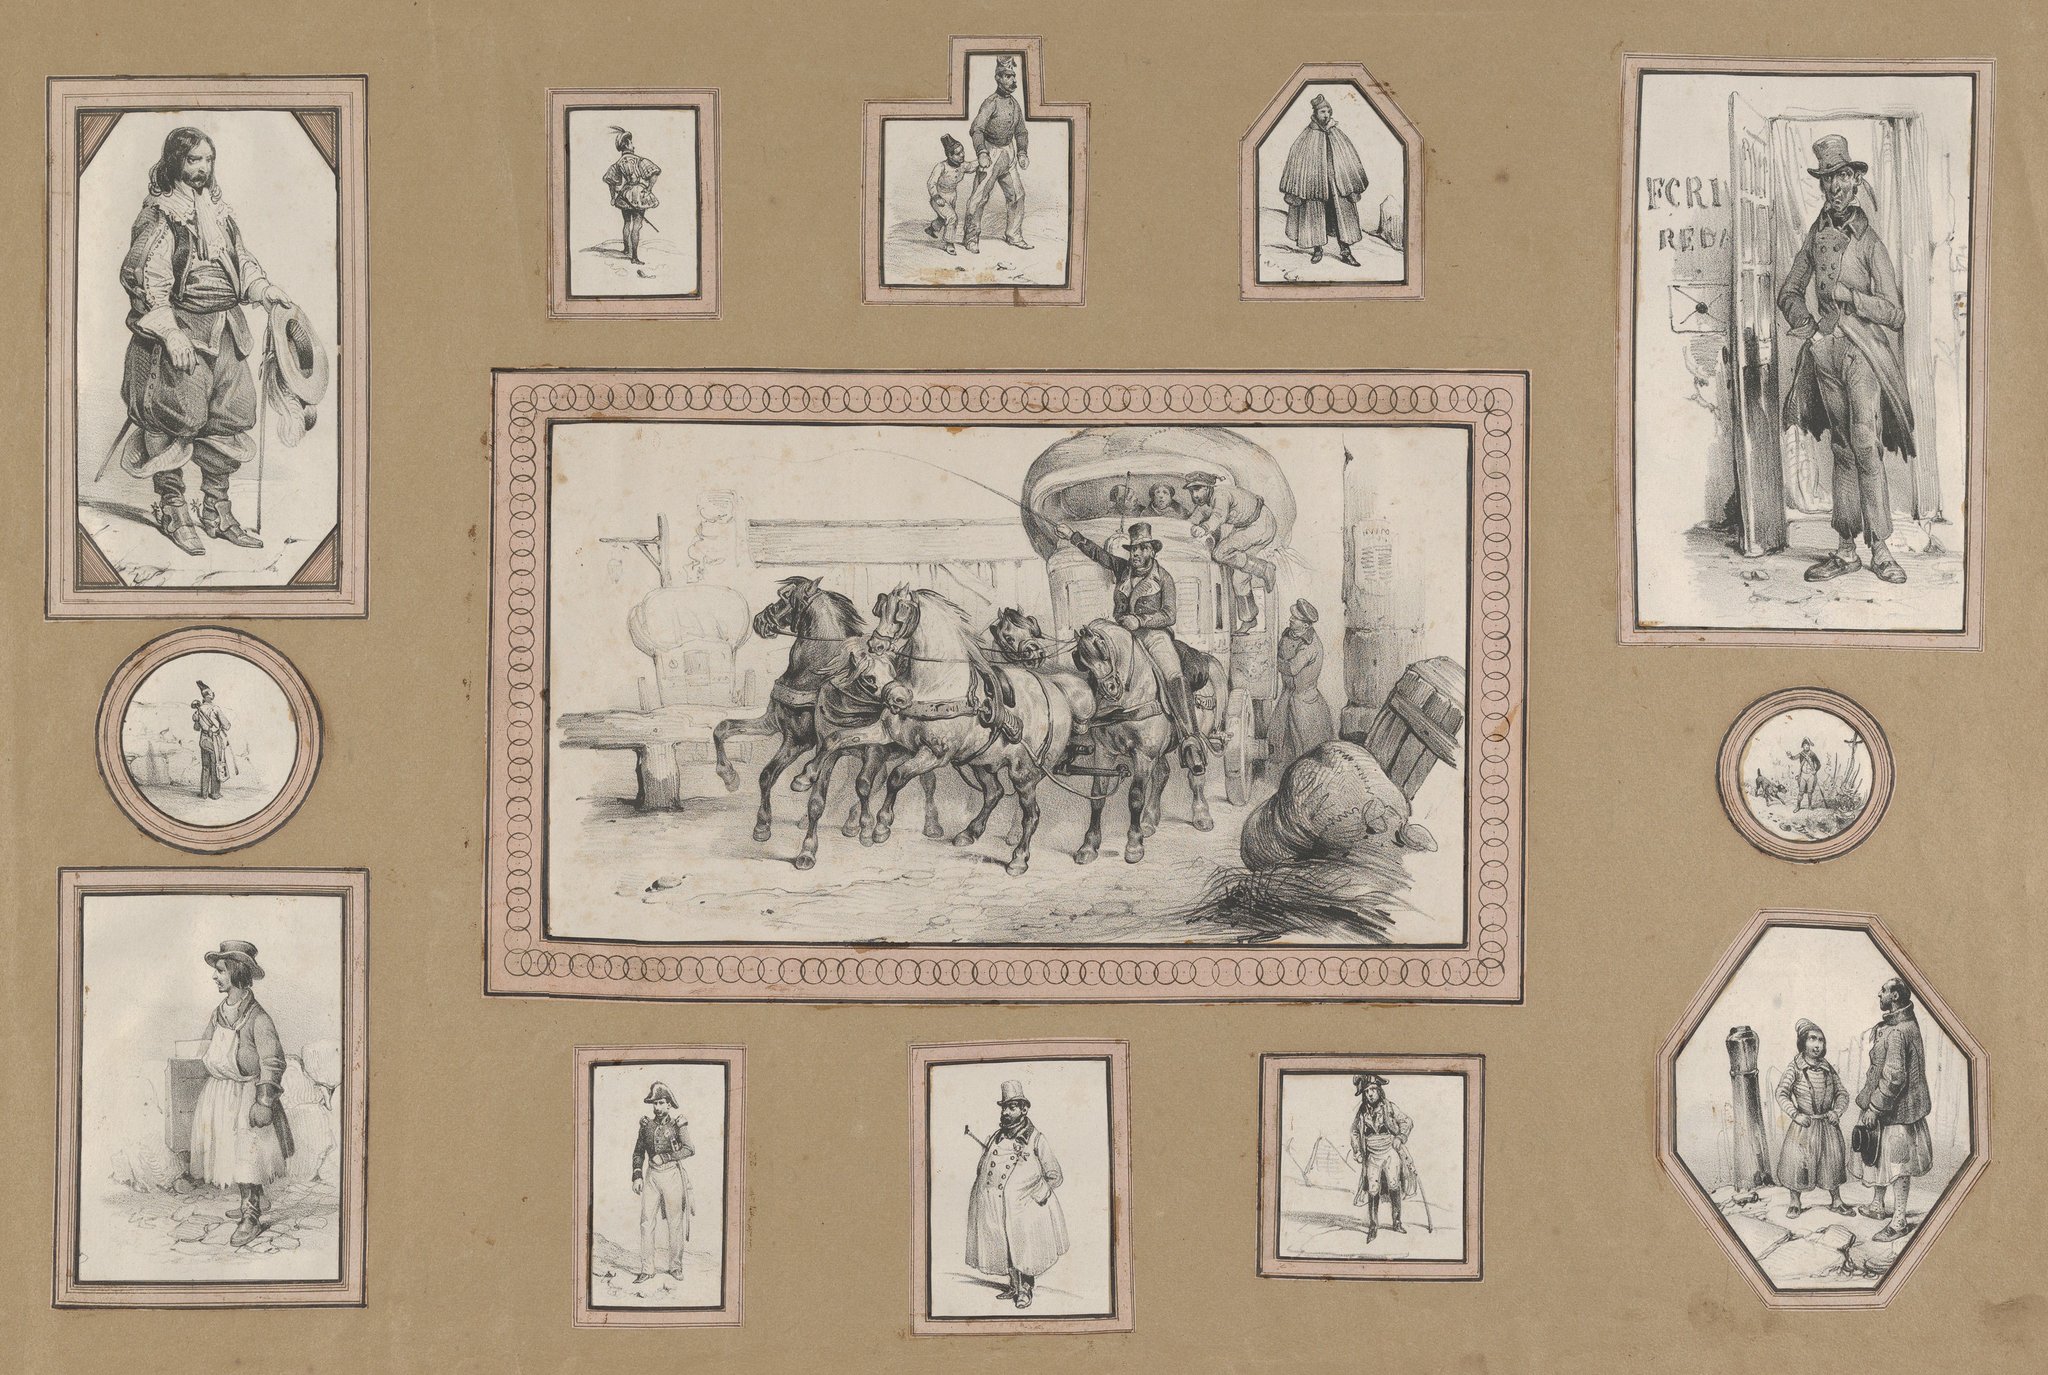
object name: print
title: 13 mounted prints depicting a carriage scene at center surrounded by various men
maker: victor adam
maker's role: artist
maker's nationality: french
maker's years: 1801-1866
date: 1834-1866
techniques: lithograph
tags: men,carriages